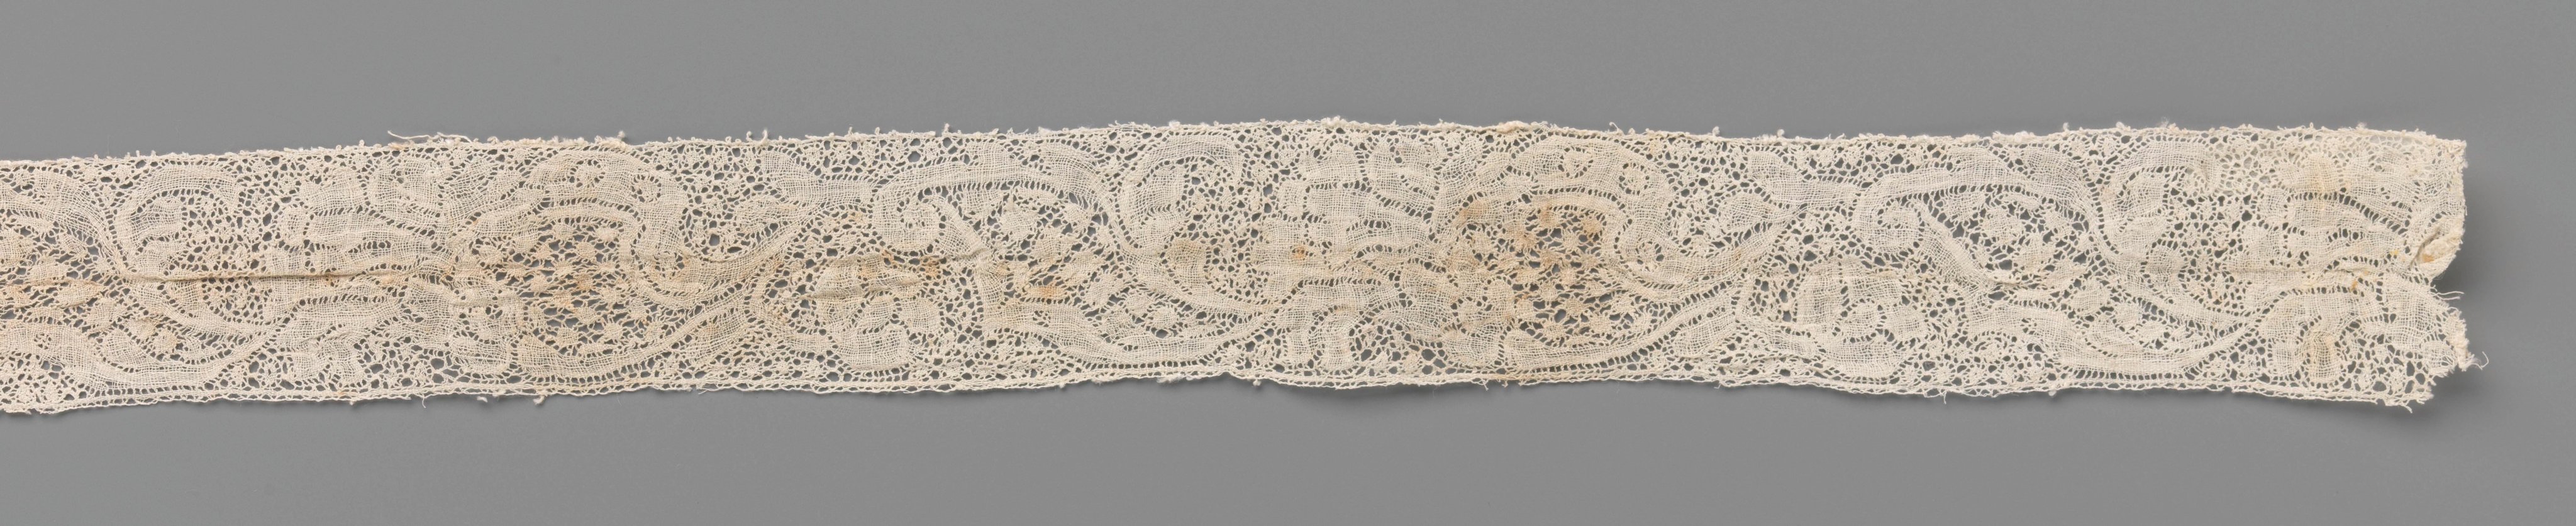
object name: strip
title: Strook kloskant met anjer aan gebogen steel en breed s-vormig blad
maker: Anonymous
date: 1725-1740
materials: linen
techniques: lace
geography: southern netherlands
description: Strook naturelkleurige kloskant, Binche-kant. Het zich herhalende patroon bestaat uit een grote anjer aan een gebogen steel. Een kleinere gelobde bloem buigt zich aan een zijtak in tegenovergestelde richting af. Een flauw s-vormig en breed blad vormt de verbinding met de anjer uit het daaropvolgende patroon. De motieven zijn met elkaar verbonden door een siergrond, een sneeuwvlokkengrond. De motieven zijn gemaakt in linnenslag met opengewerkte randjes. In een ruimte onder de anjer is als siergrond een andere sneeuwvlokkengrond gebruikt. En in het s-vormige blad is een siergrond met op sneeuwvlokken gelijkende motiefjes gebruikt. Boven- en onderzijde zijn recht afgewerkt, waarbij de onderzijde is voorzien van picots, die niet meer allemaal in tact zijn.